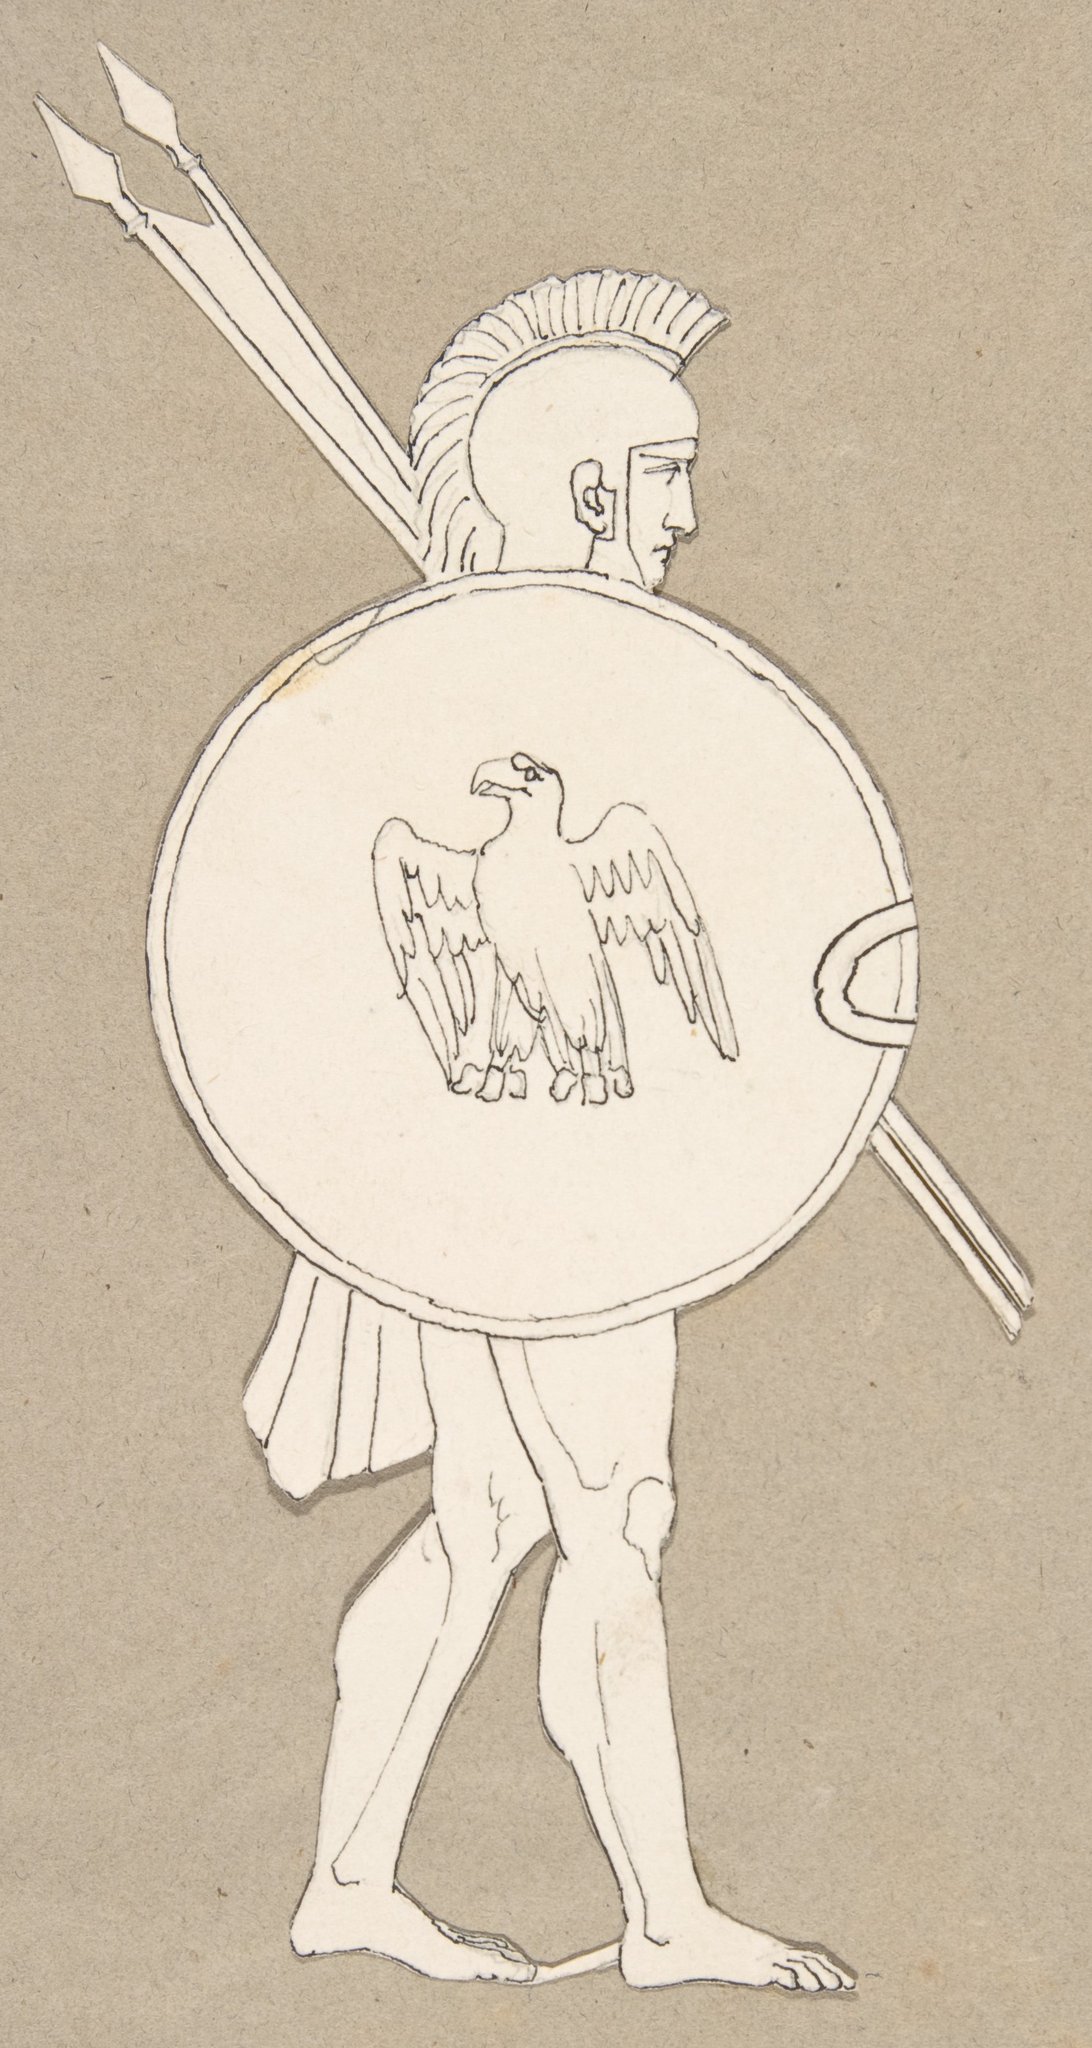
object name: drawing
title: Design for large fireplace white tiles produced in Wedgwood's factory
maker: john flaxman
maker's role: artist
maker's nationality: british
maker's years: 1755-1826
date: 1801-1900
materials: graphite, ink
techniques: pen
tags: birds,soldiers,shields